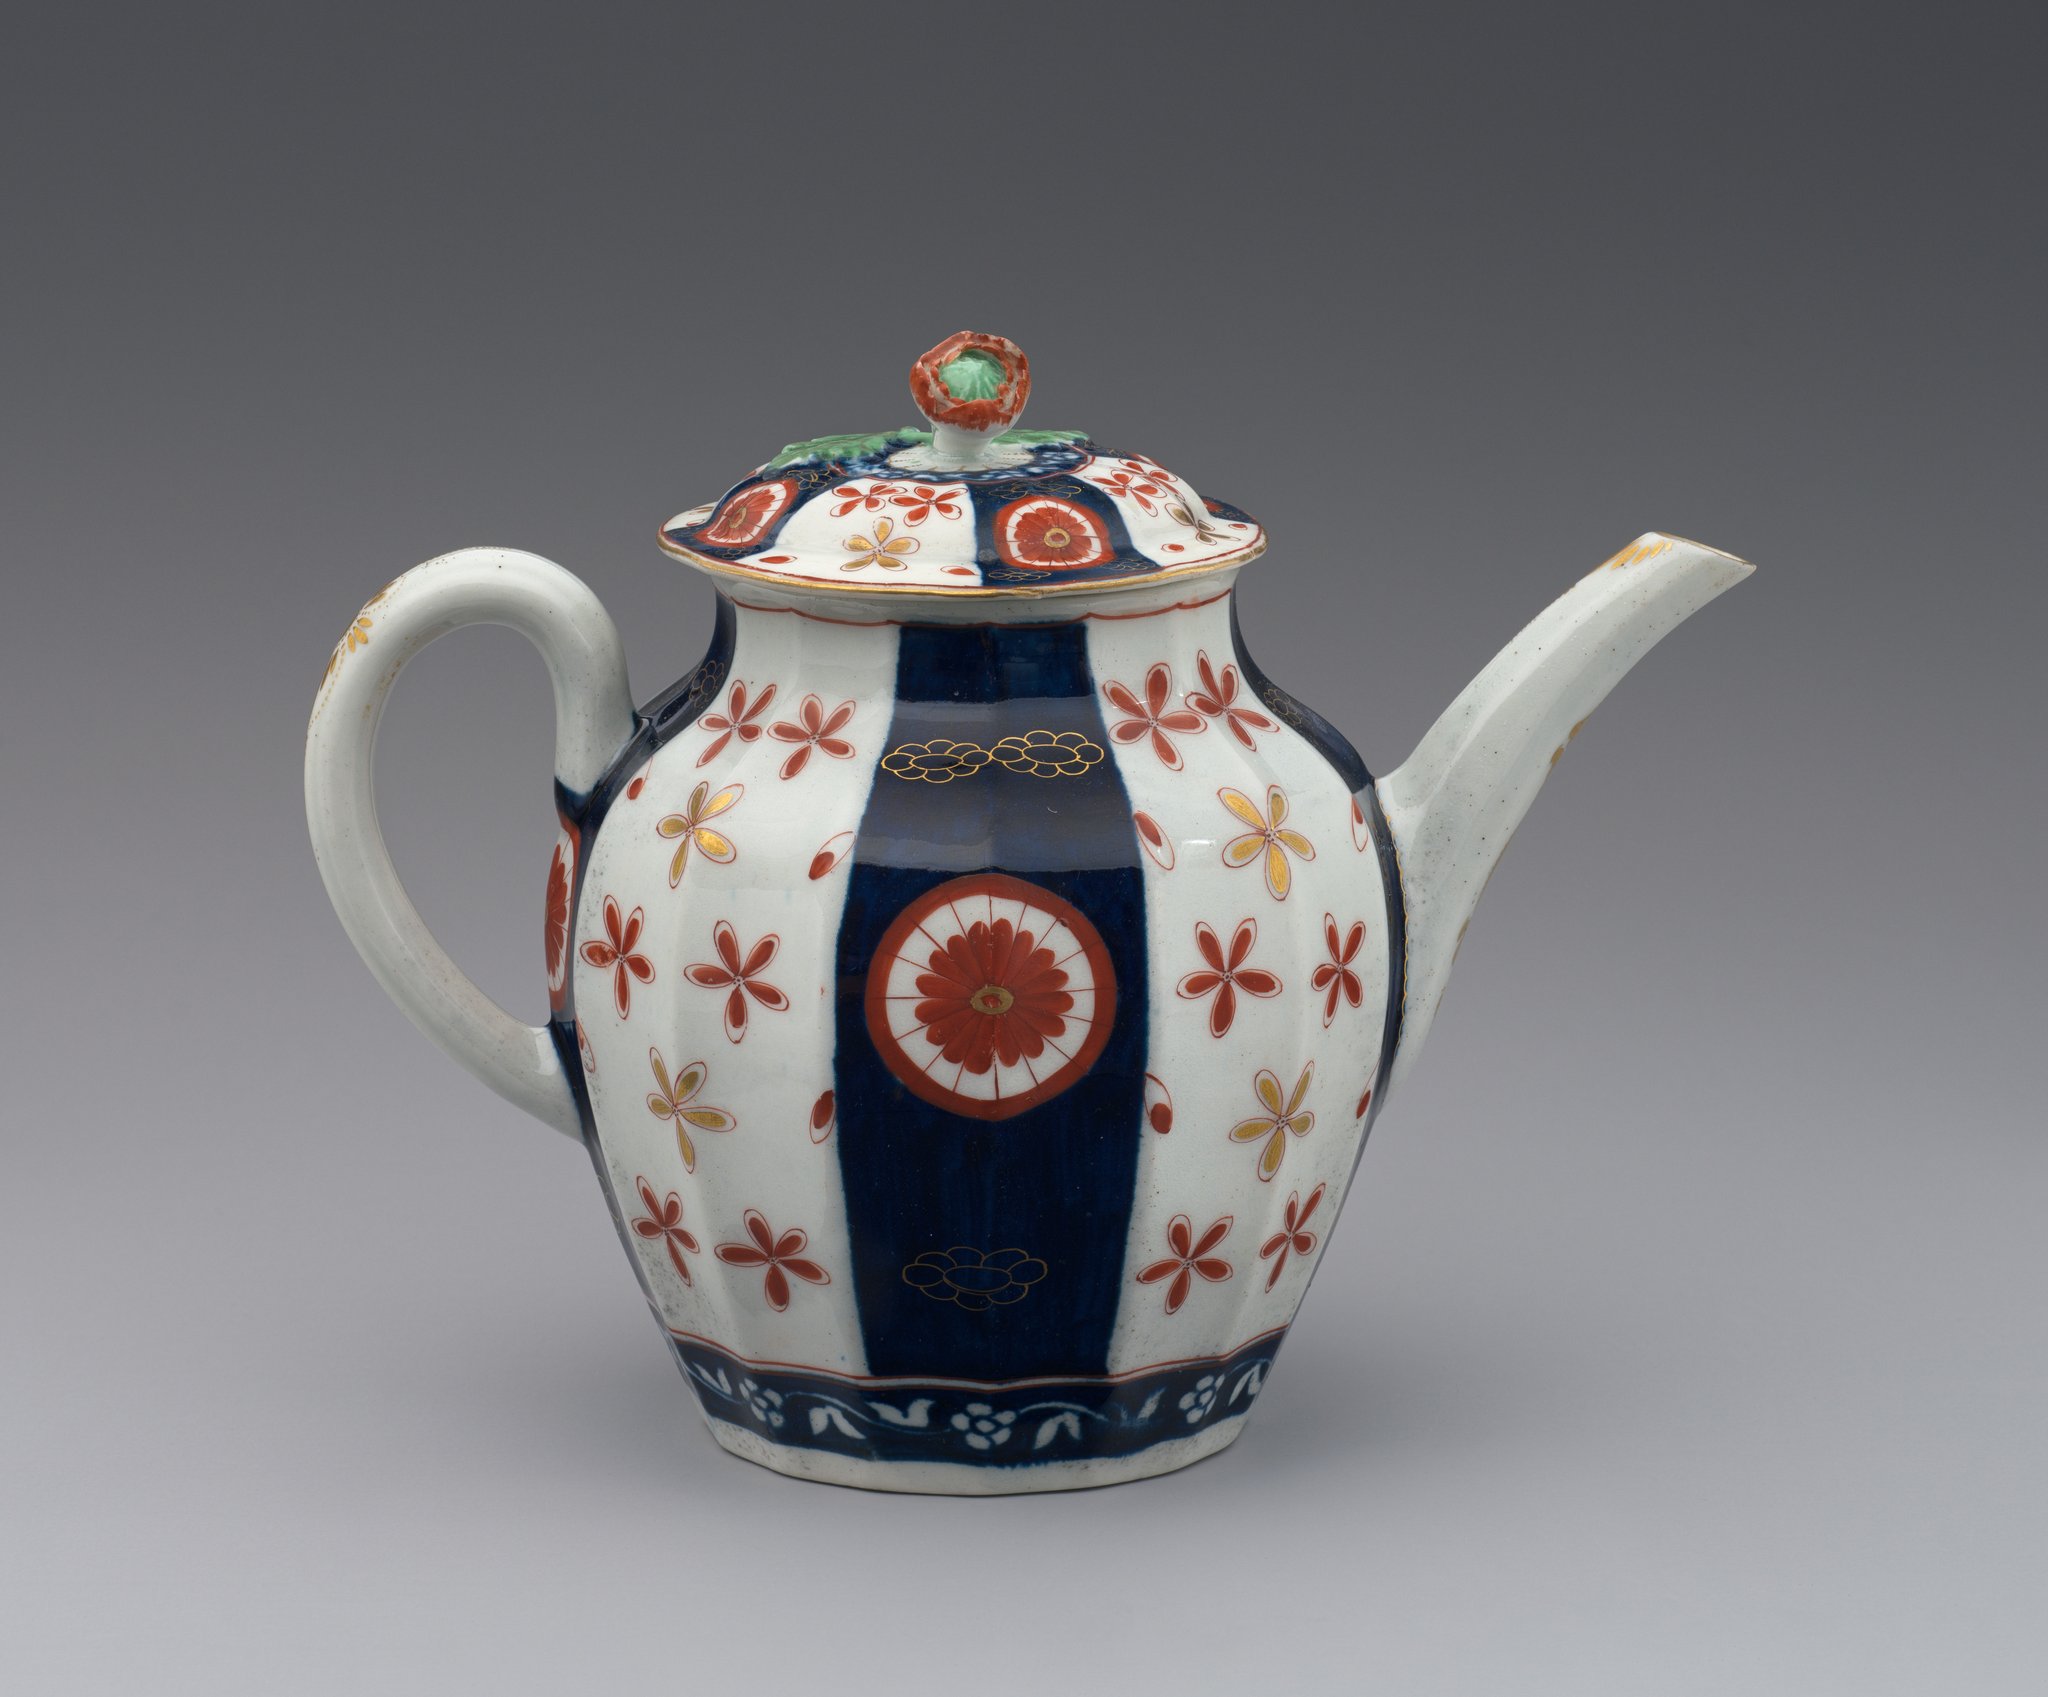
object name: teapot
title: Teapot (part of a service)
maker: worcester factory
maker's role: factory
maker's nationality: british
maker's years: 1751-2008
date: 1765-1775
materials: soft paste porcelain